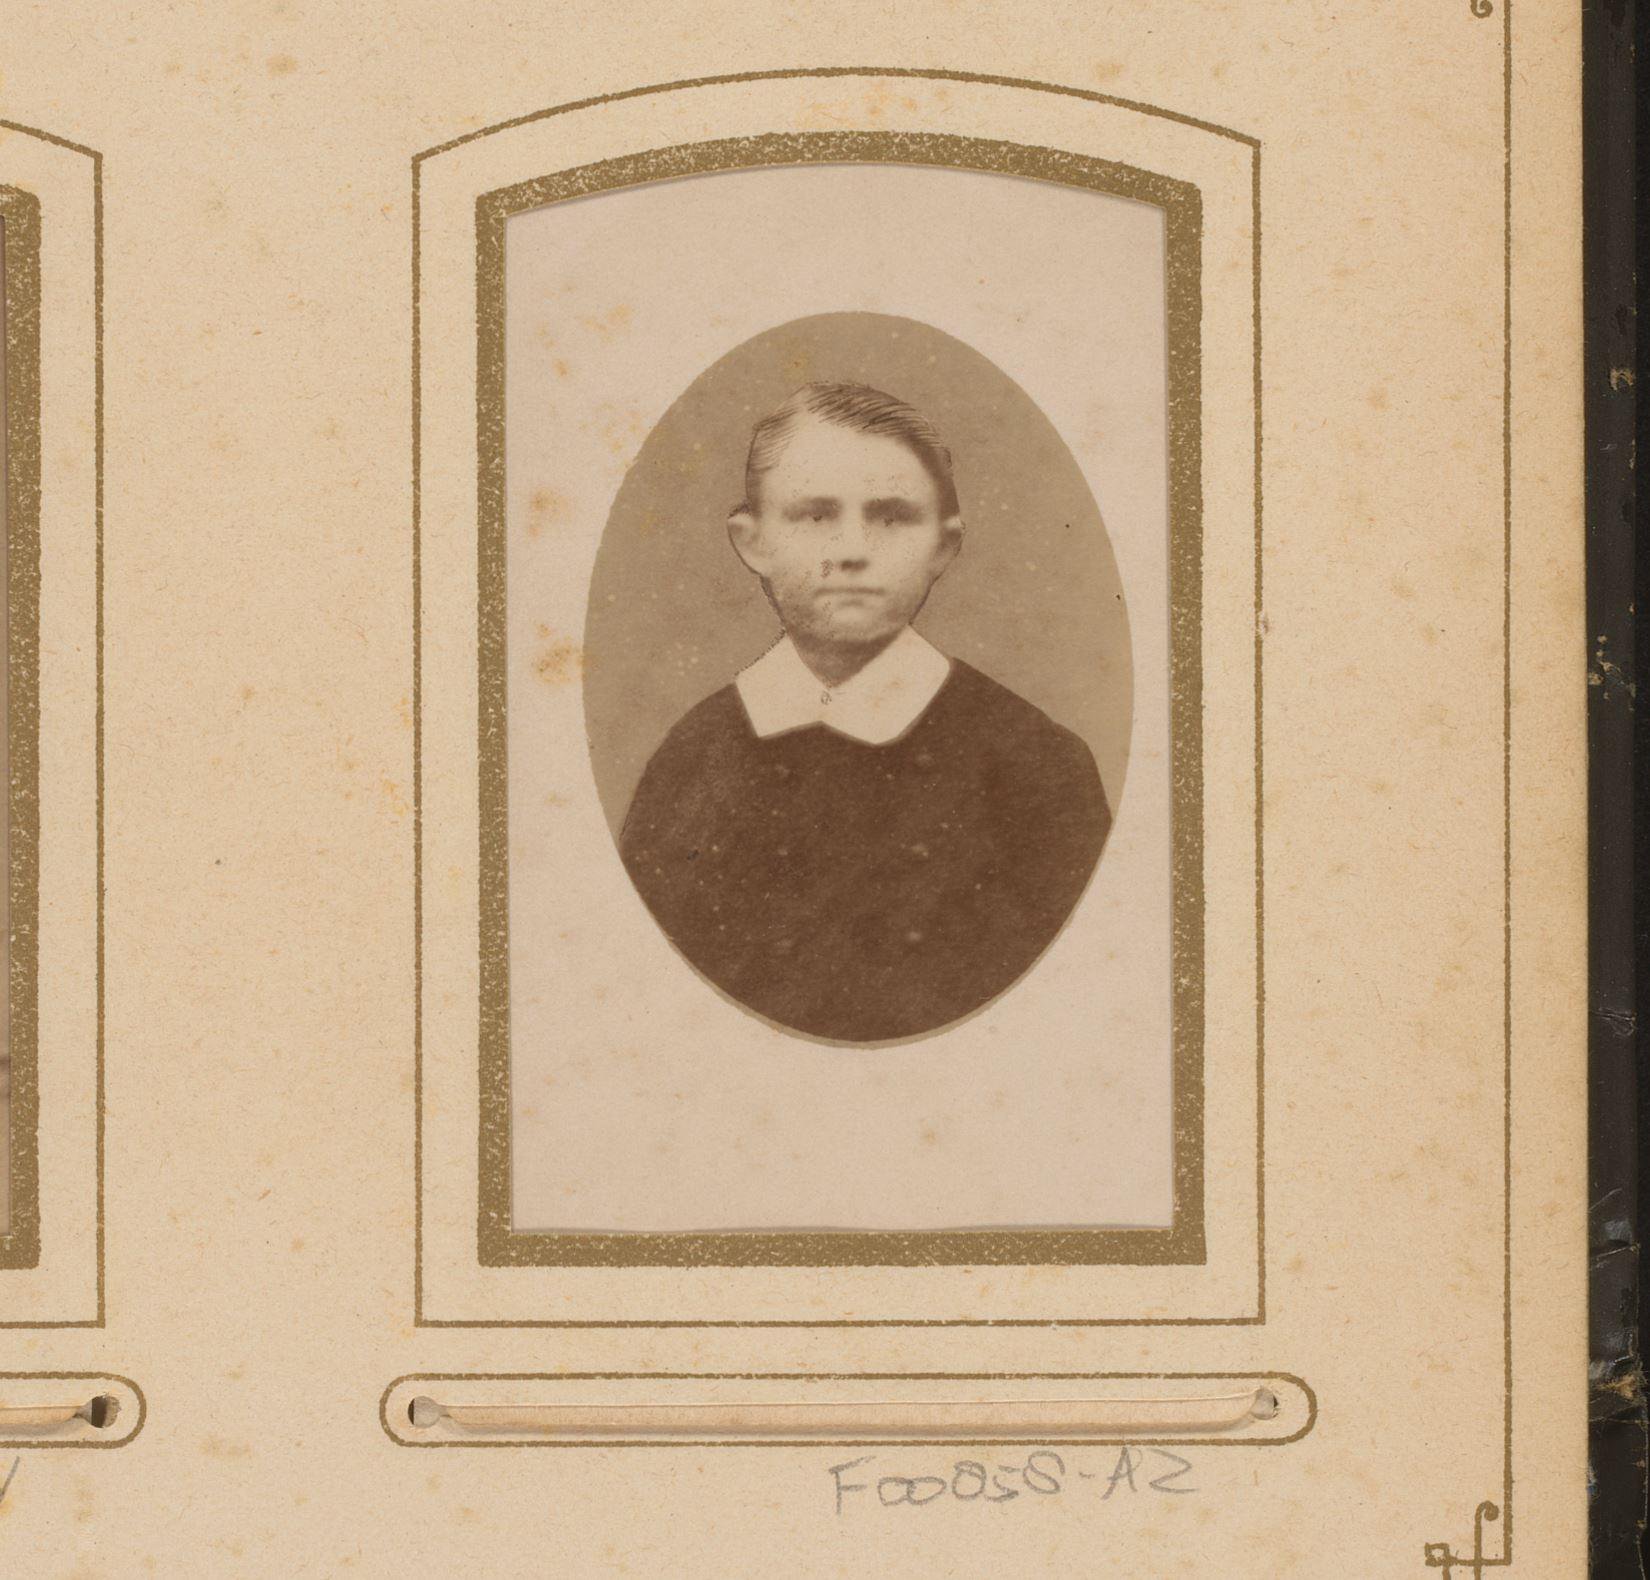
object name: album leaf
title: Portret van een jongen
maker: albert a. kleintjes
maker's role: fotograaf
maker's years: 1854-1942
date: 1883-1900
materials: cardboard, photographic support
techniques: albumen print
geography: hoorn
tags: boy (child between toddler and youth)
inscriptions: inscription: ‘Hoorn, Kerkstraat, 4e huis v.d. Kaasmarkt’